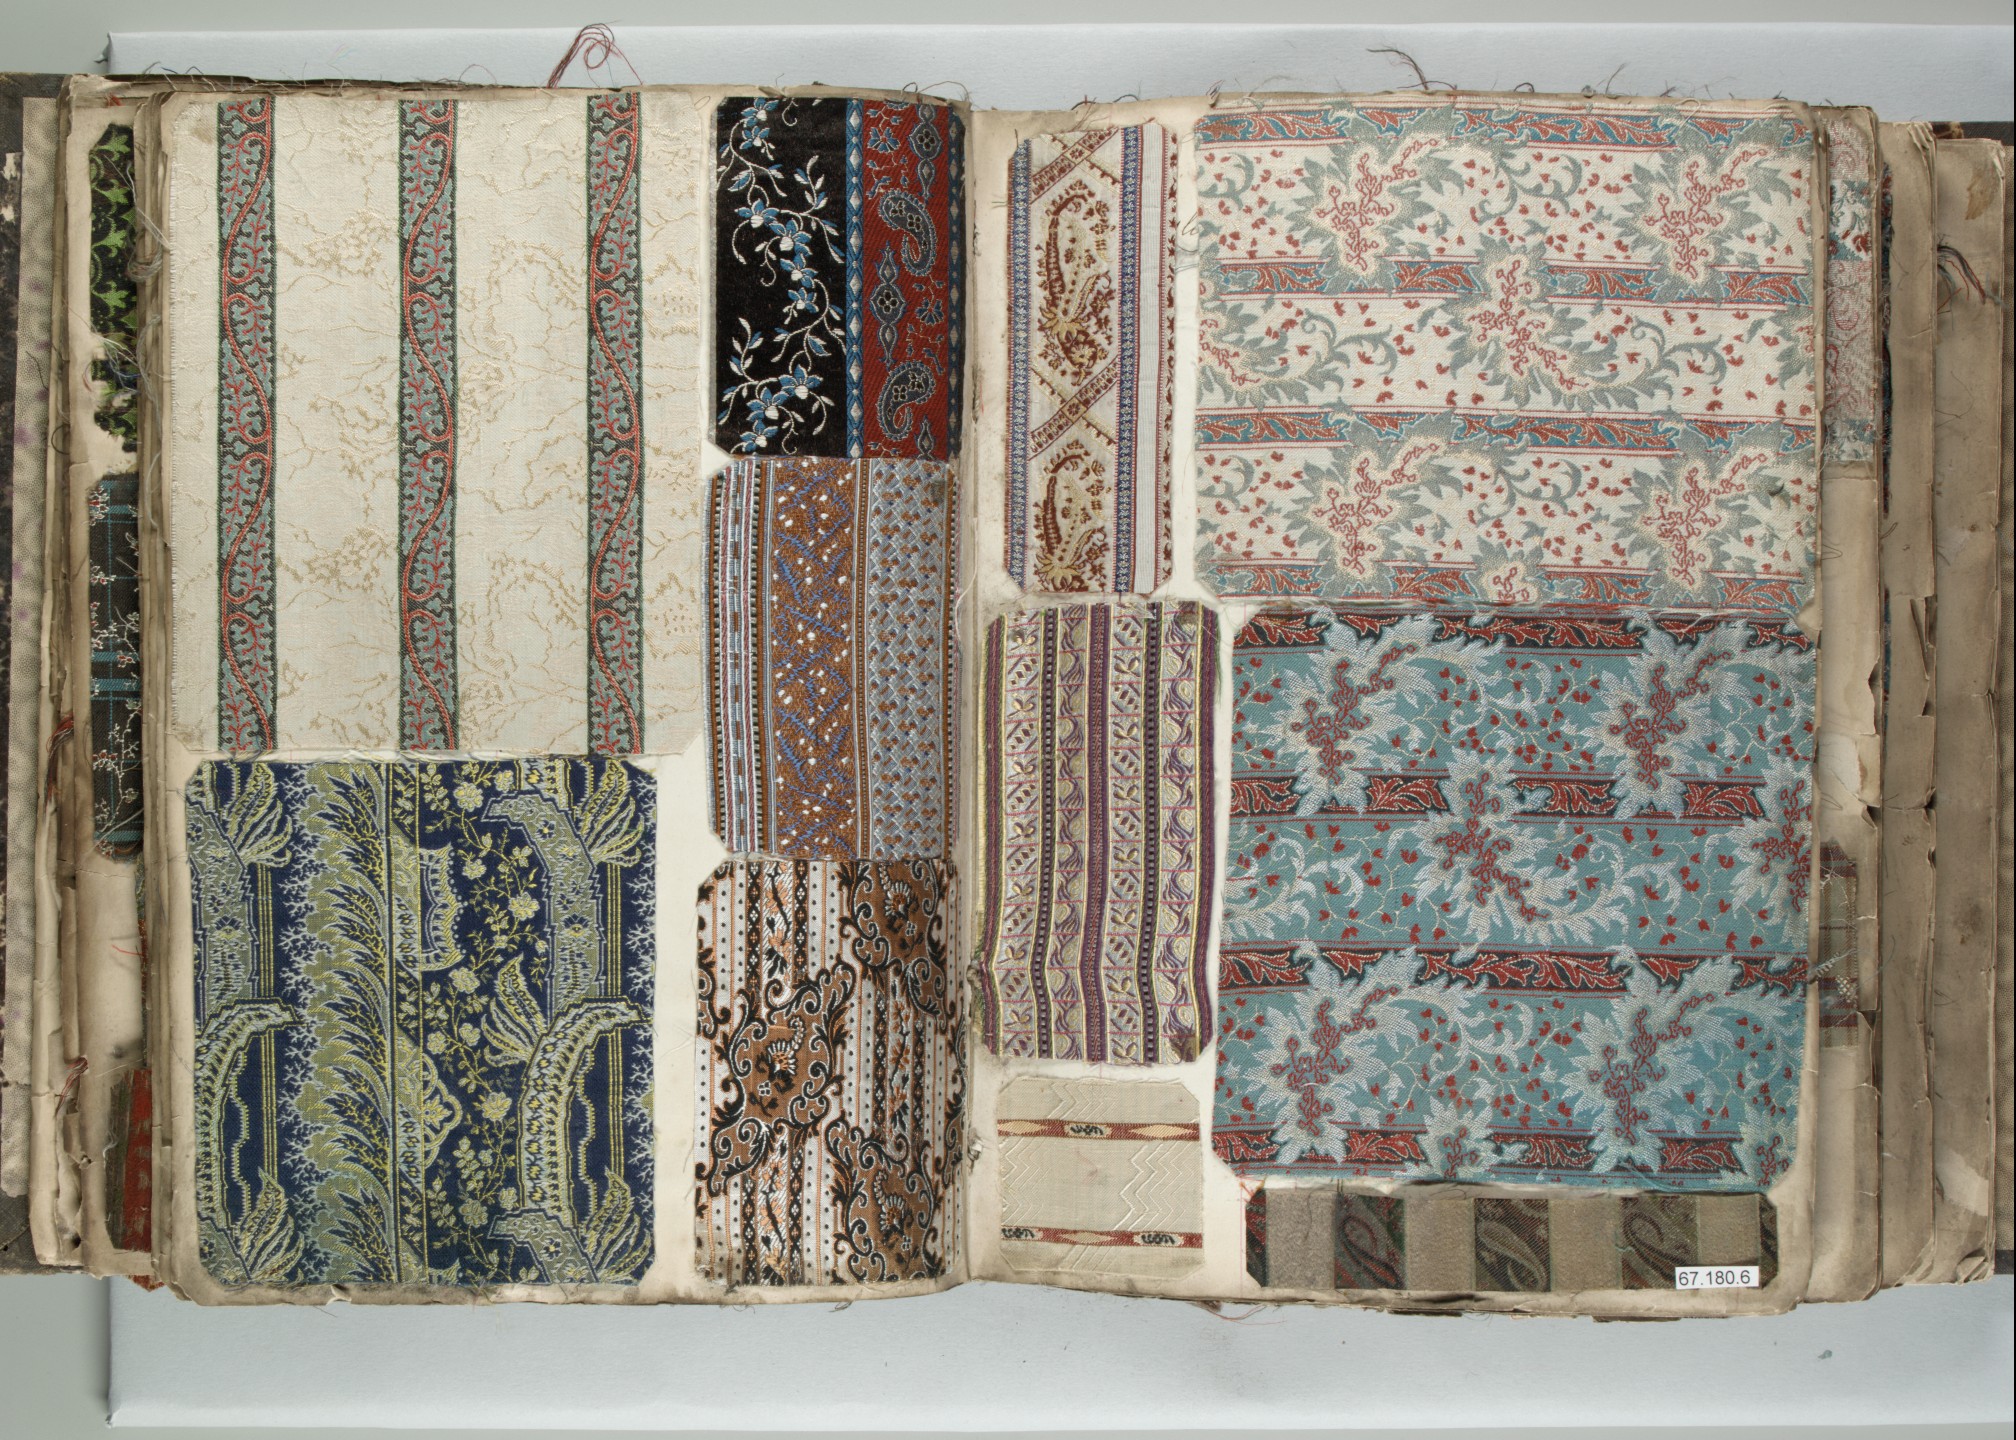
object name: sample book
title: Textile Sample Book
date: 1801-1900